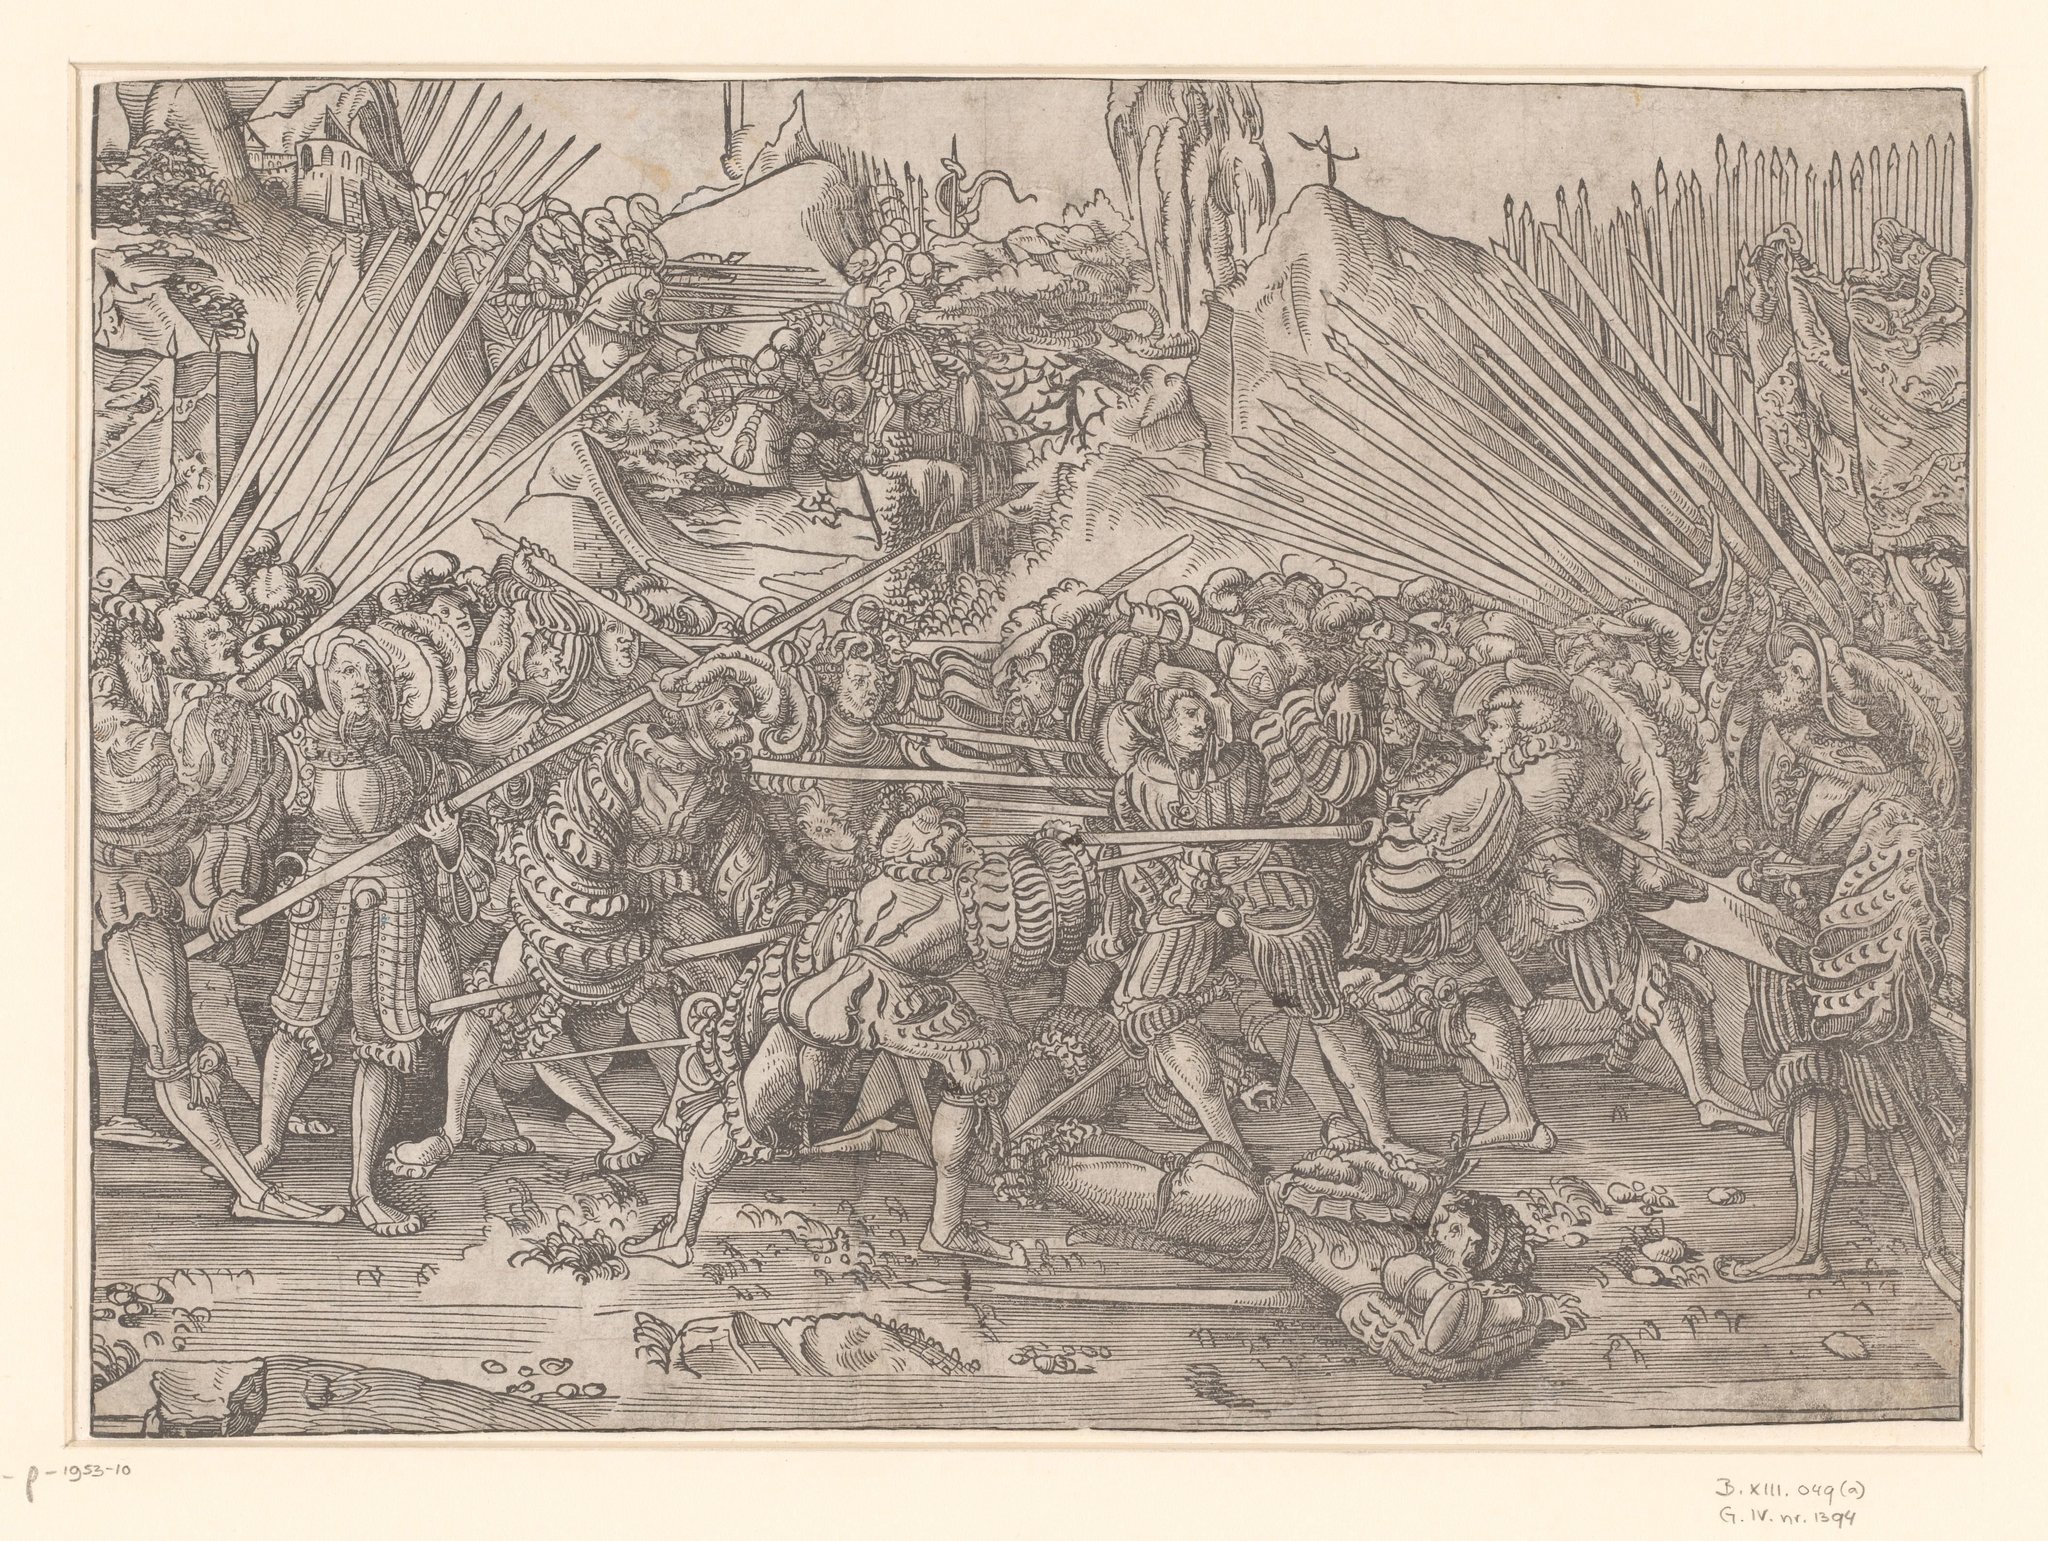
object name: print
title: Veldslag tussen landsknechten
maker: Anonymous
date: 1520-1562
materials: paper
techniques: woodcut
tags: battle (+ land forces)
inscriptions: collector's mark: Lugt 2228